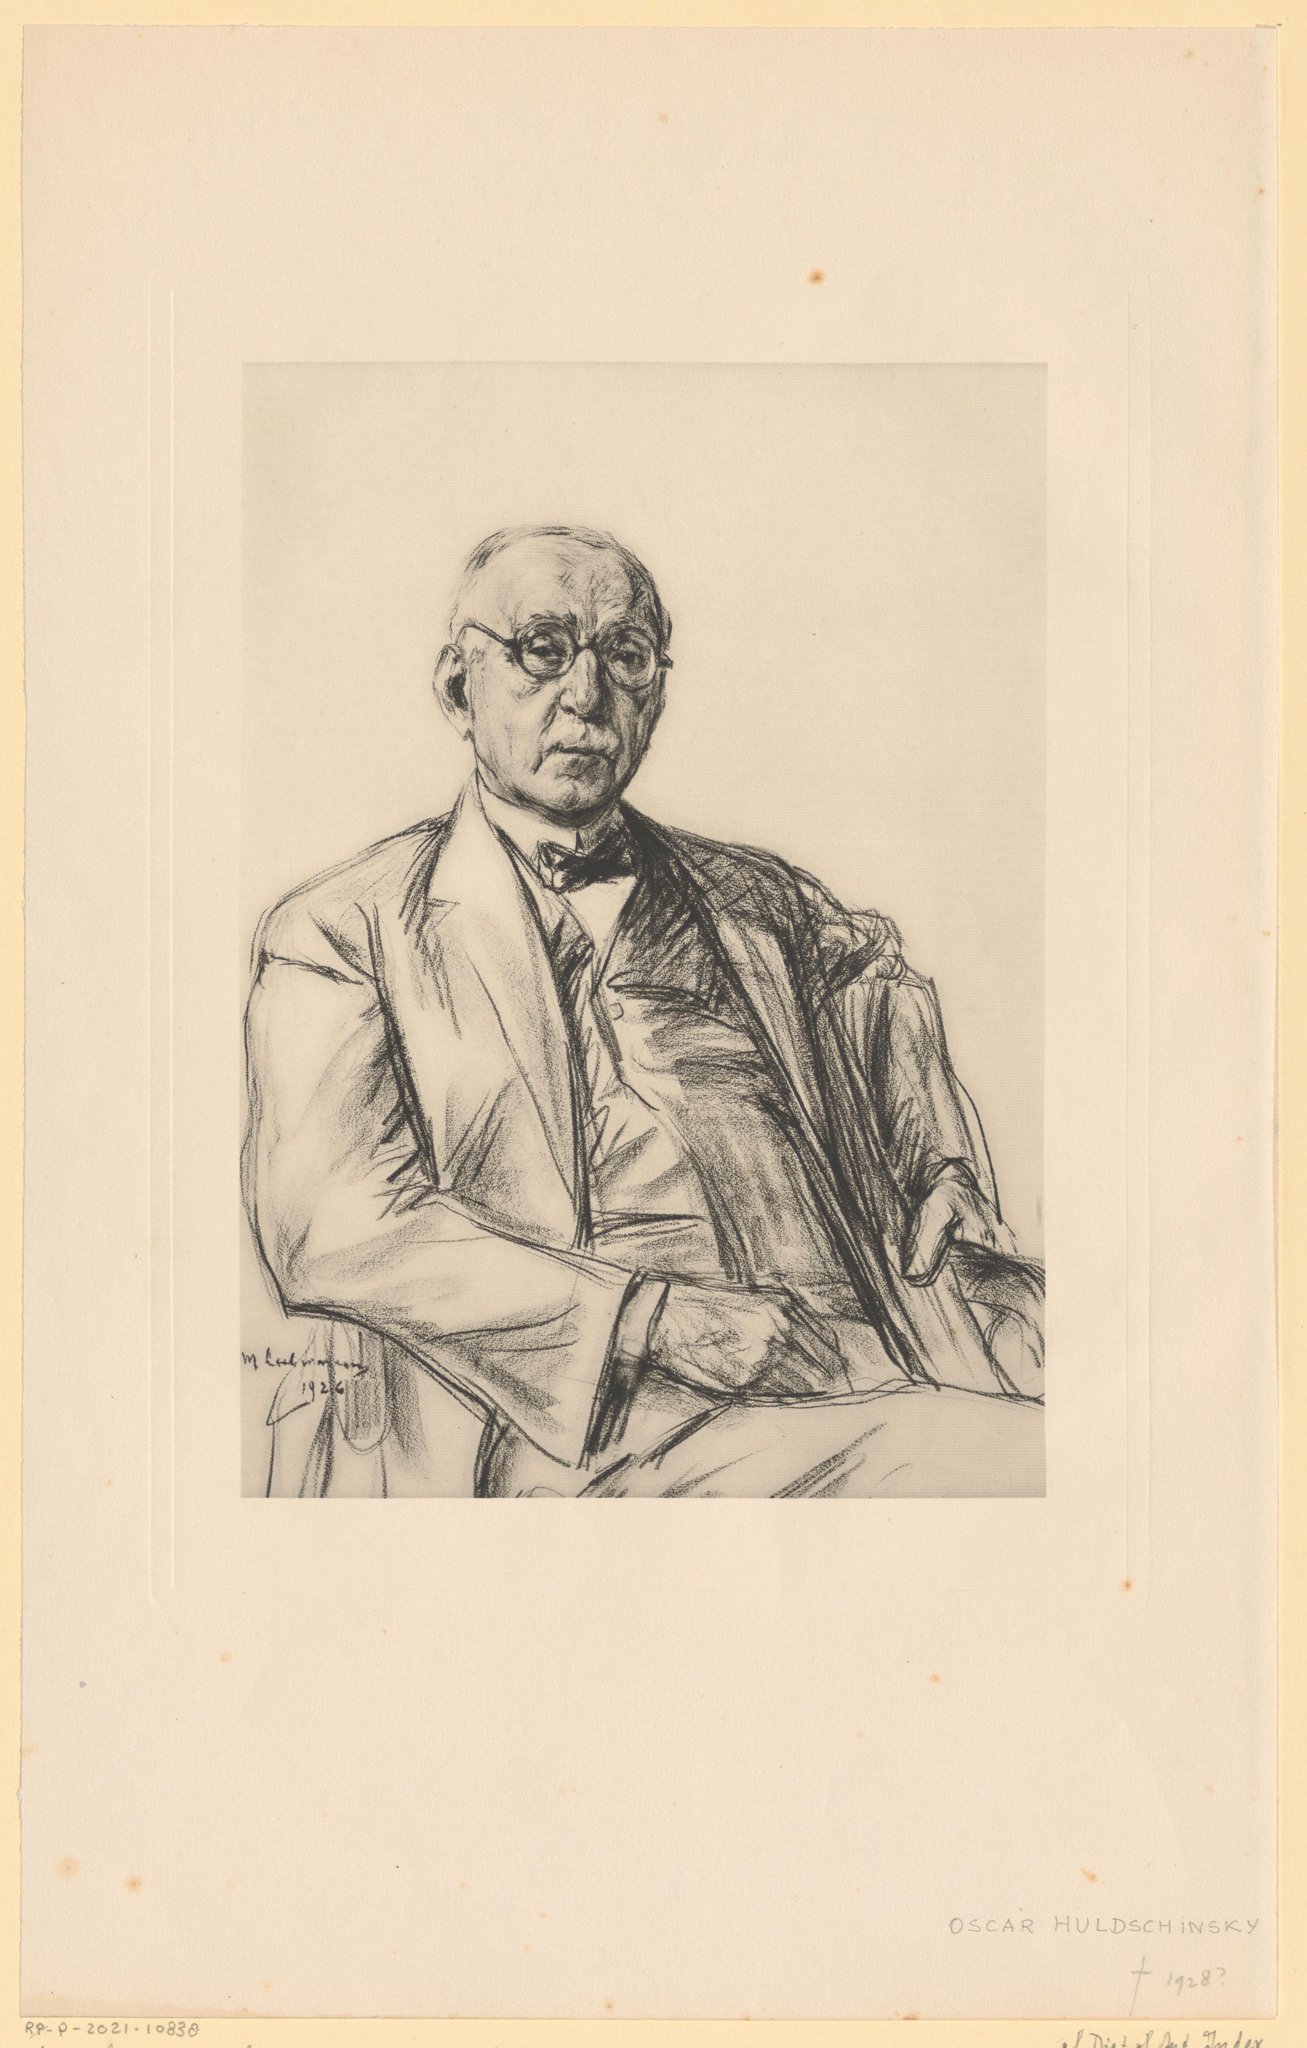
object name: photomechanical print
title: Portret van Oscar Huldschinsky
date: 1926-1940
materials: paper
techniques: rotogravure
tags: eyeglasses, spectacles, historical persons